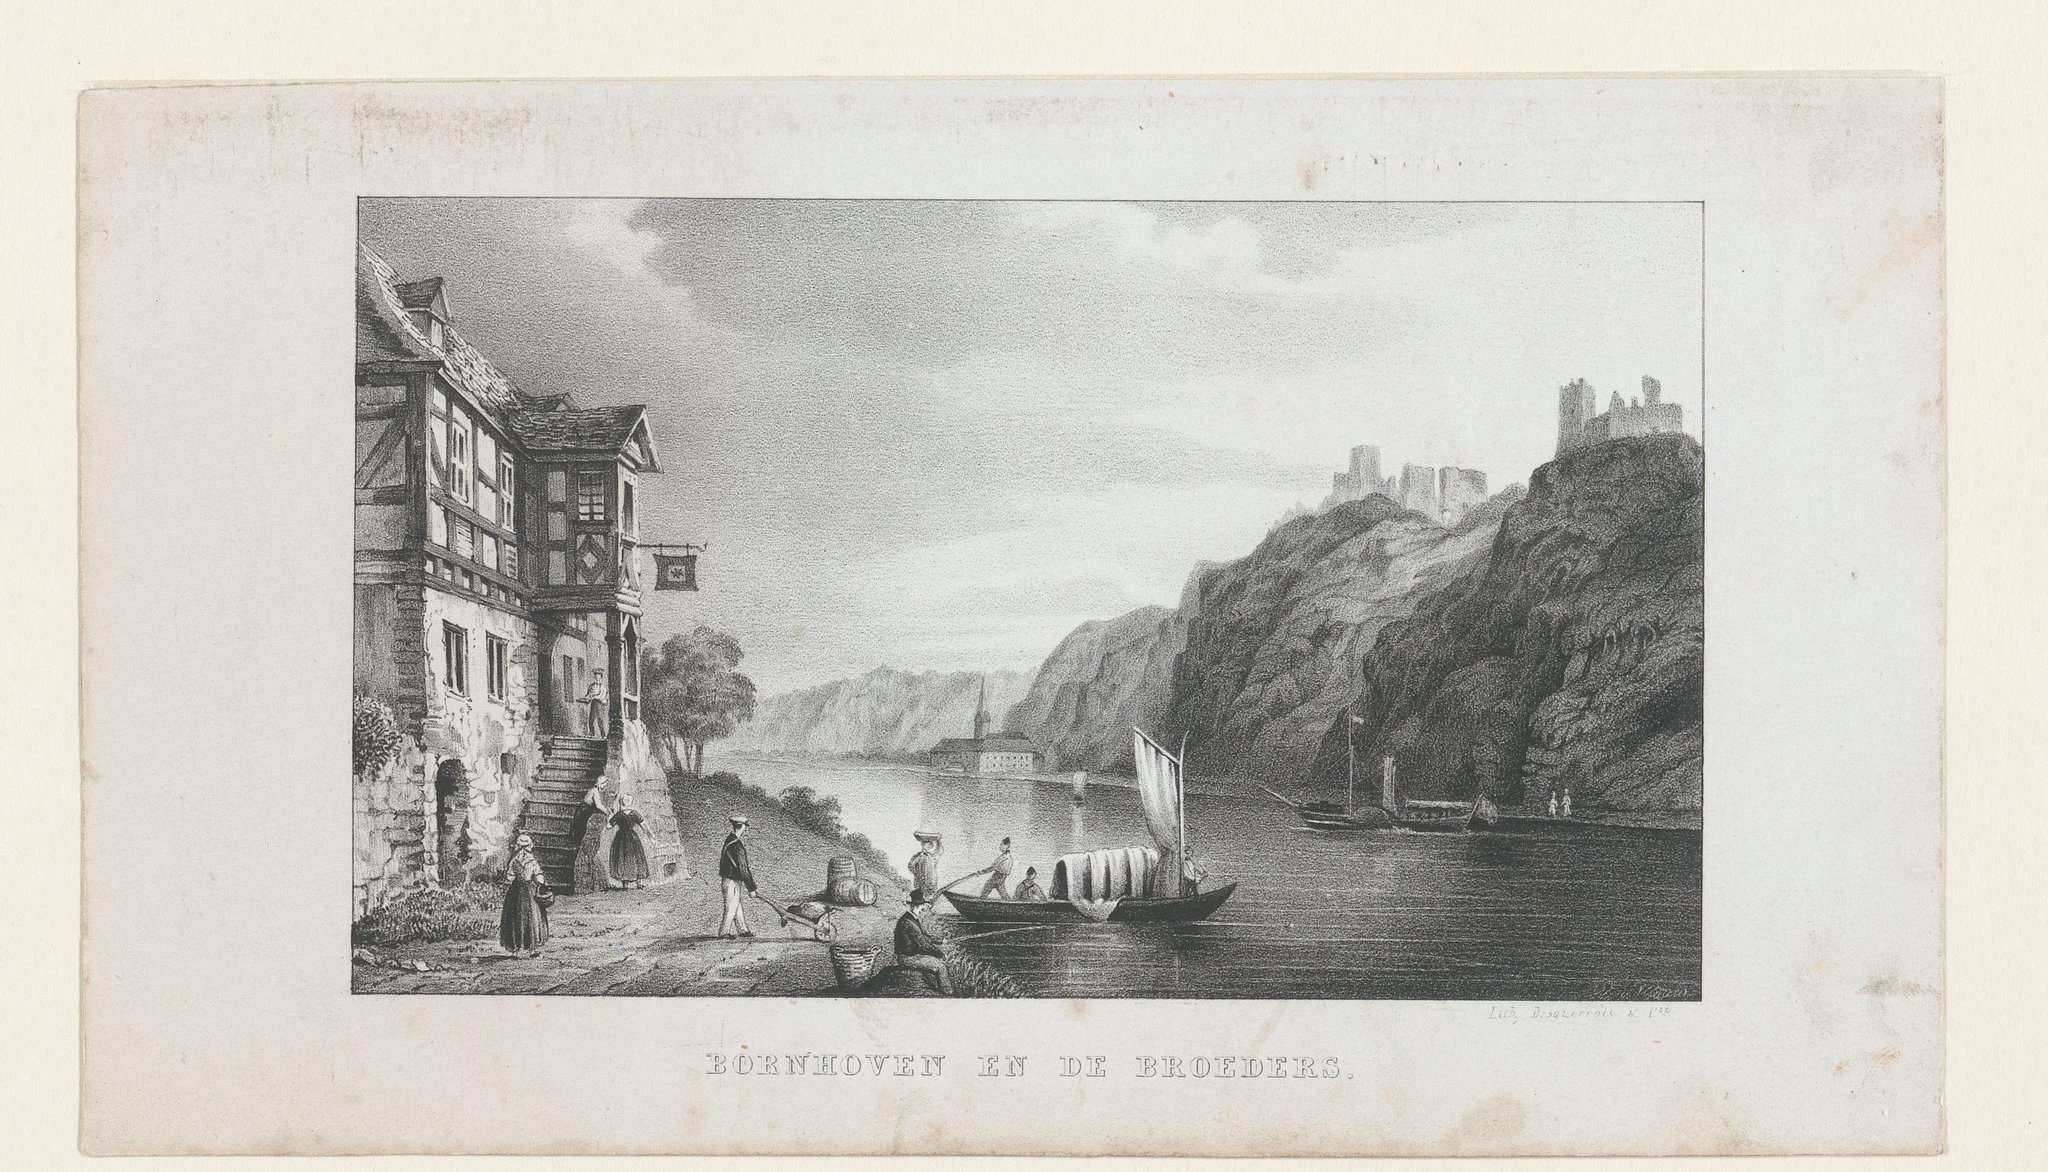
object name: print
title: Gezicht op de 'Vijandige Broers', bij Kamp-Bornhofen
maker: willem bastiaan van wouw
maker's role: print maker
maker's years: 1822-1878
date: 1856-1869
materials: paper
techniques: lithograph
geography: amsterdam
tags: prospect of village, silhouette of village, castle, river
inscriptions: collector's mark: Lugt 2228